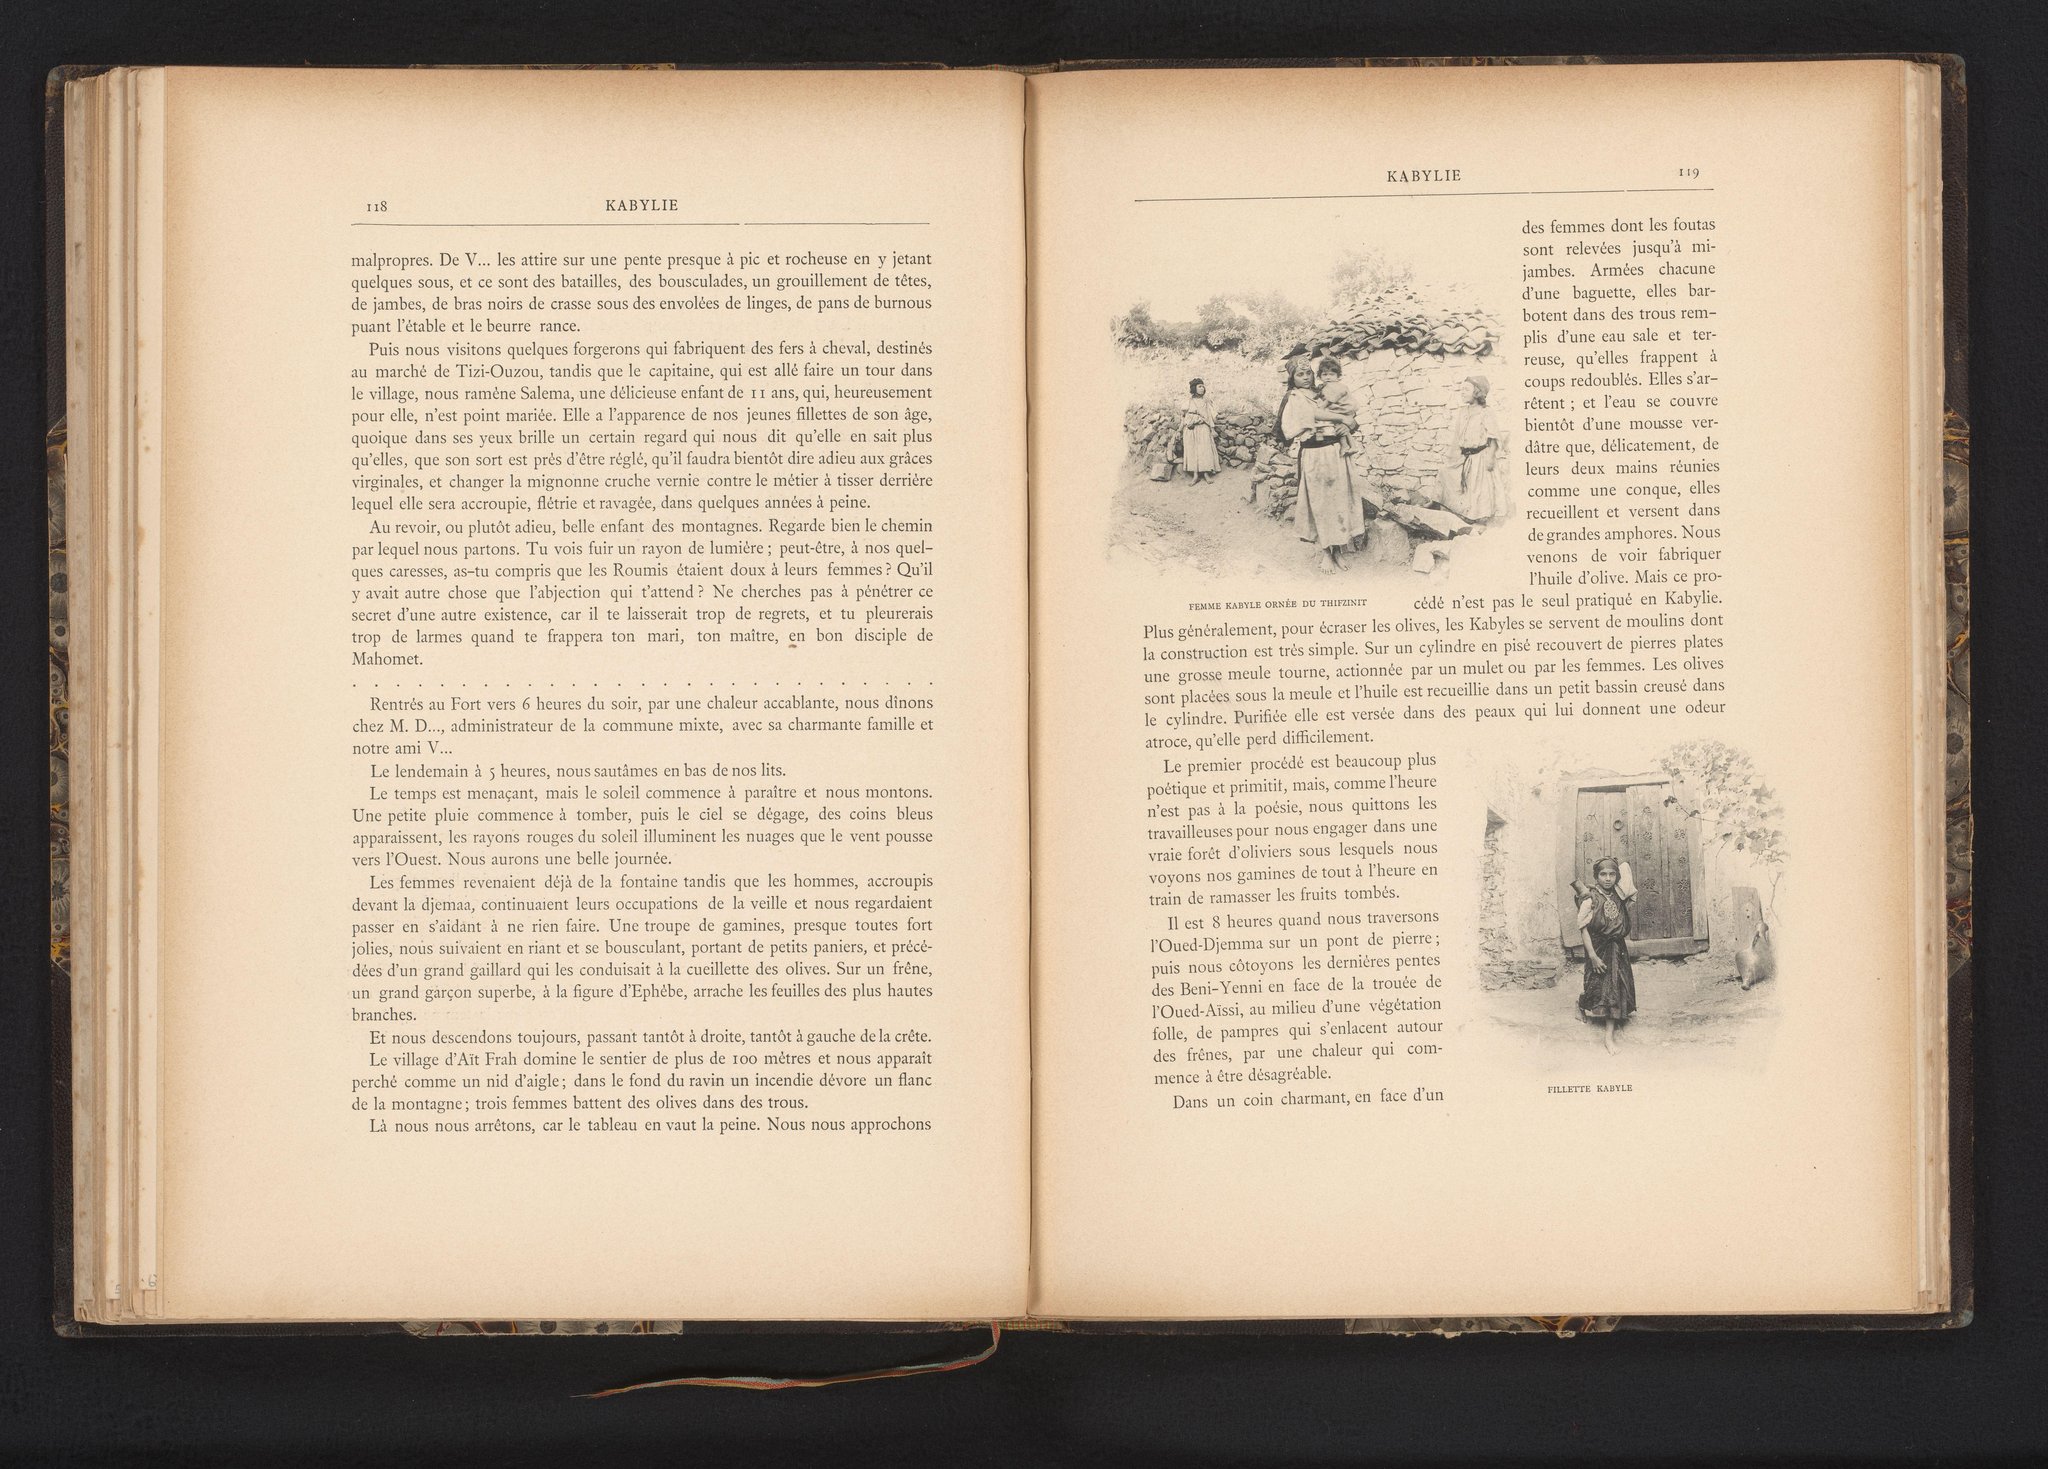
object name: page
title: Femme Kabyle Ornée du Thifzinit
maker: jules gervais-courtellemont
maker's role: fotograaf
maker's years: 1863-1931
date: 1888-1893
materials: paper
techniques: photograph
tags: adult woman, child, street